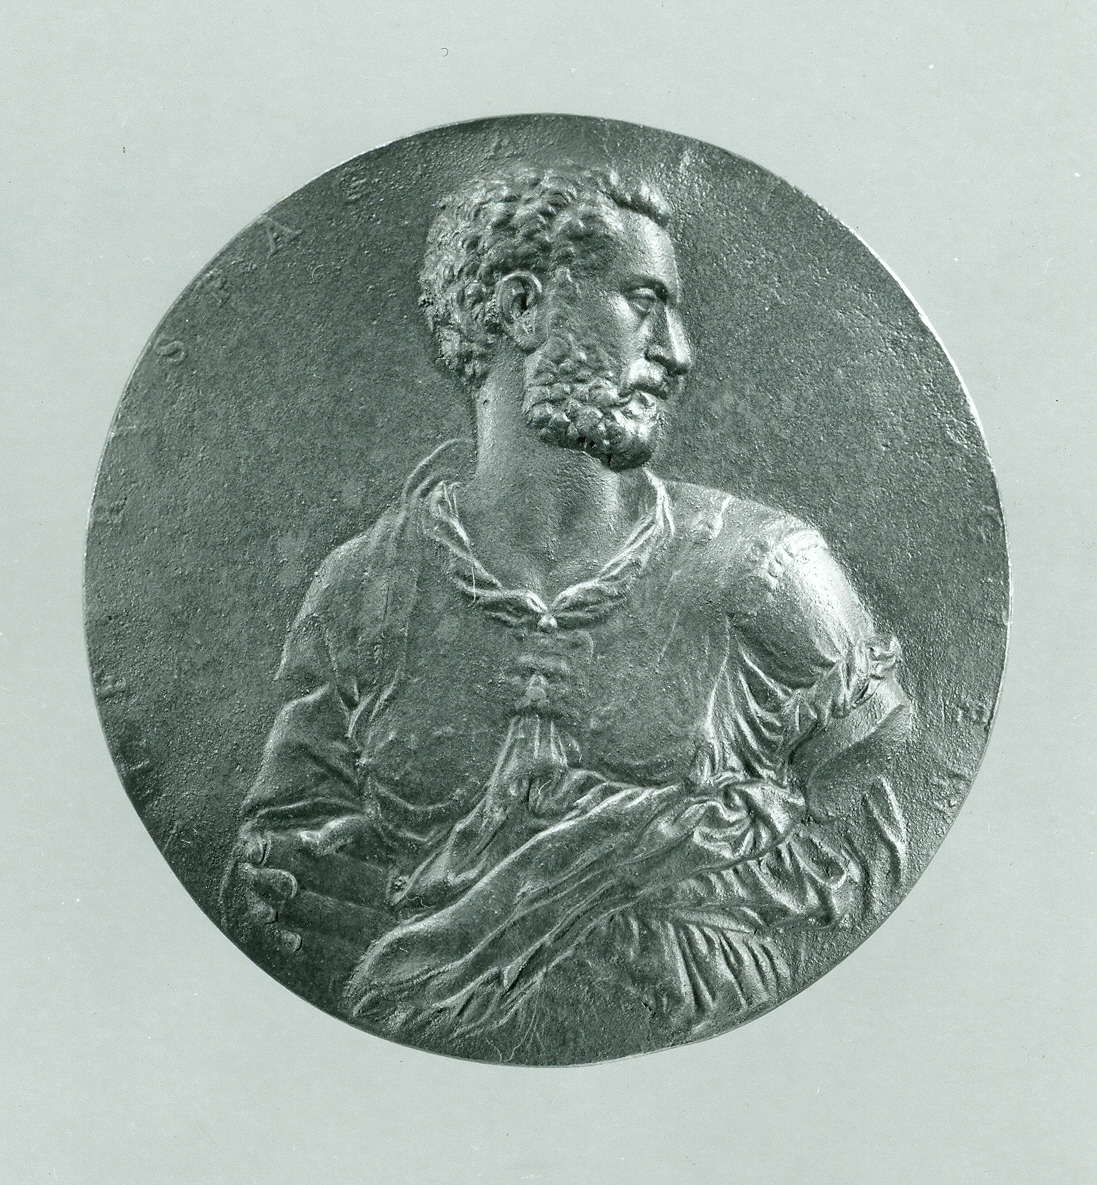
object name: medal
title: Medal: Self-portrait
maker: alfonso ruspagiari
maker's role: artist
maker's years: 1521-1576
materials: bronze, copper alloy, patina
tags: men,self-portraits